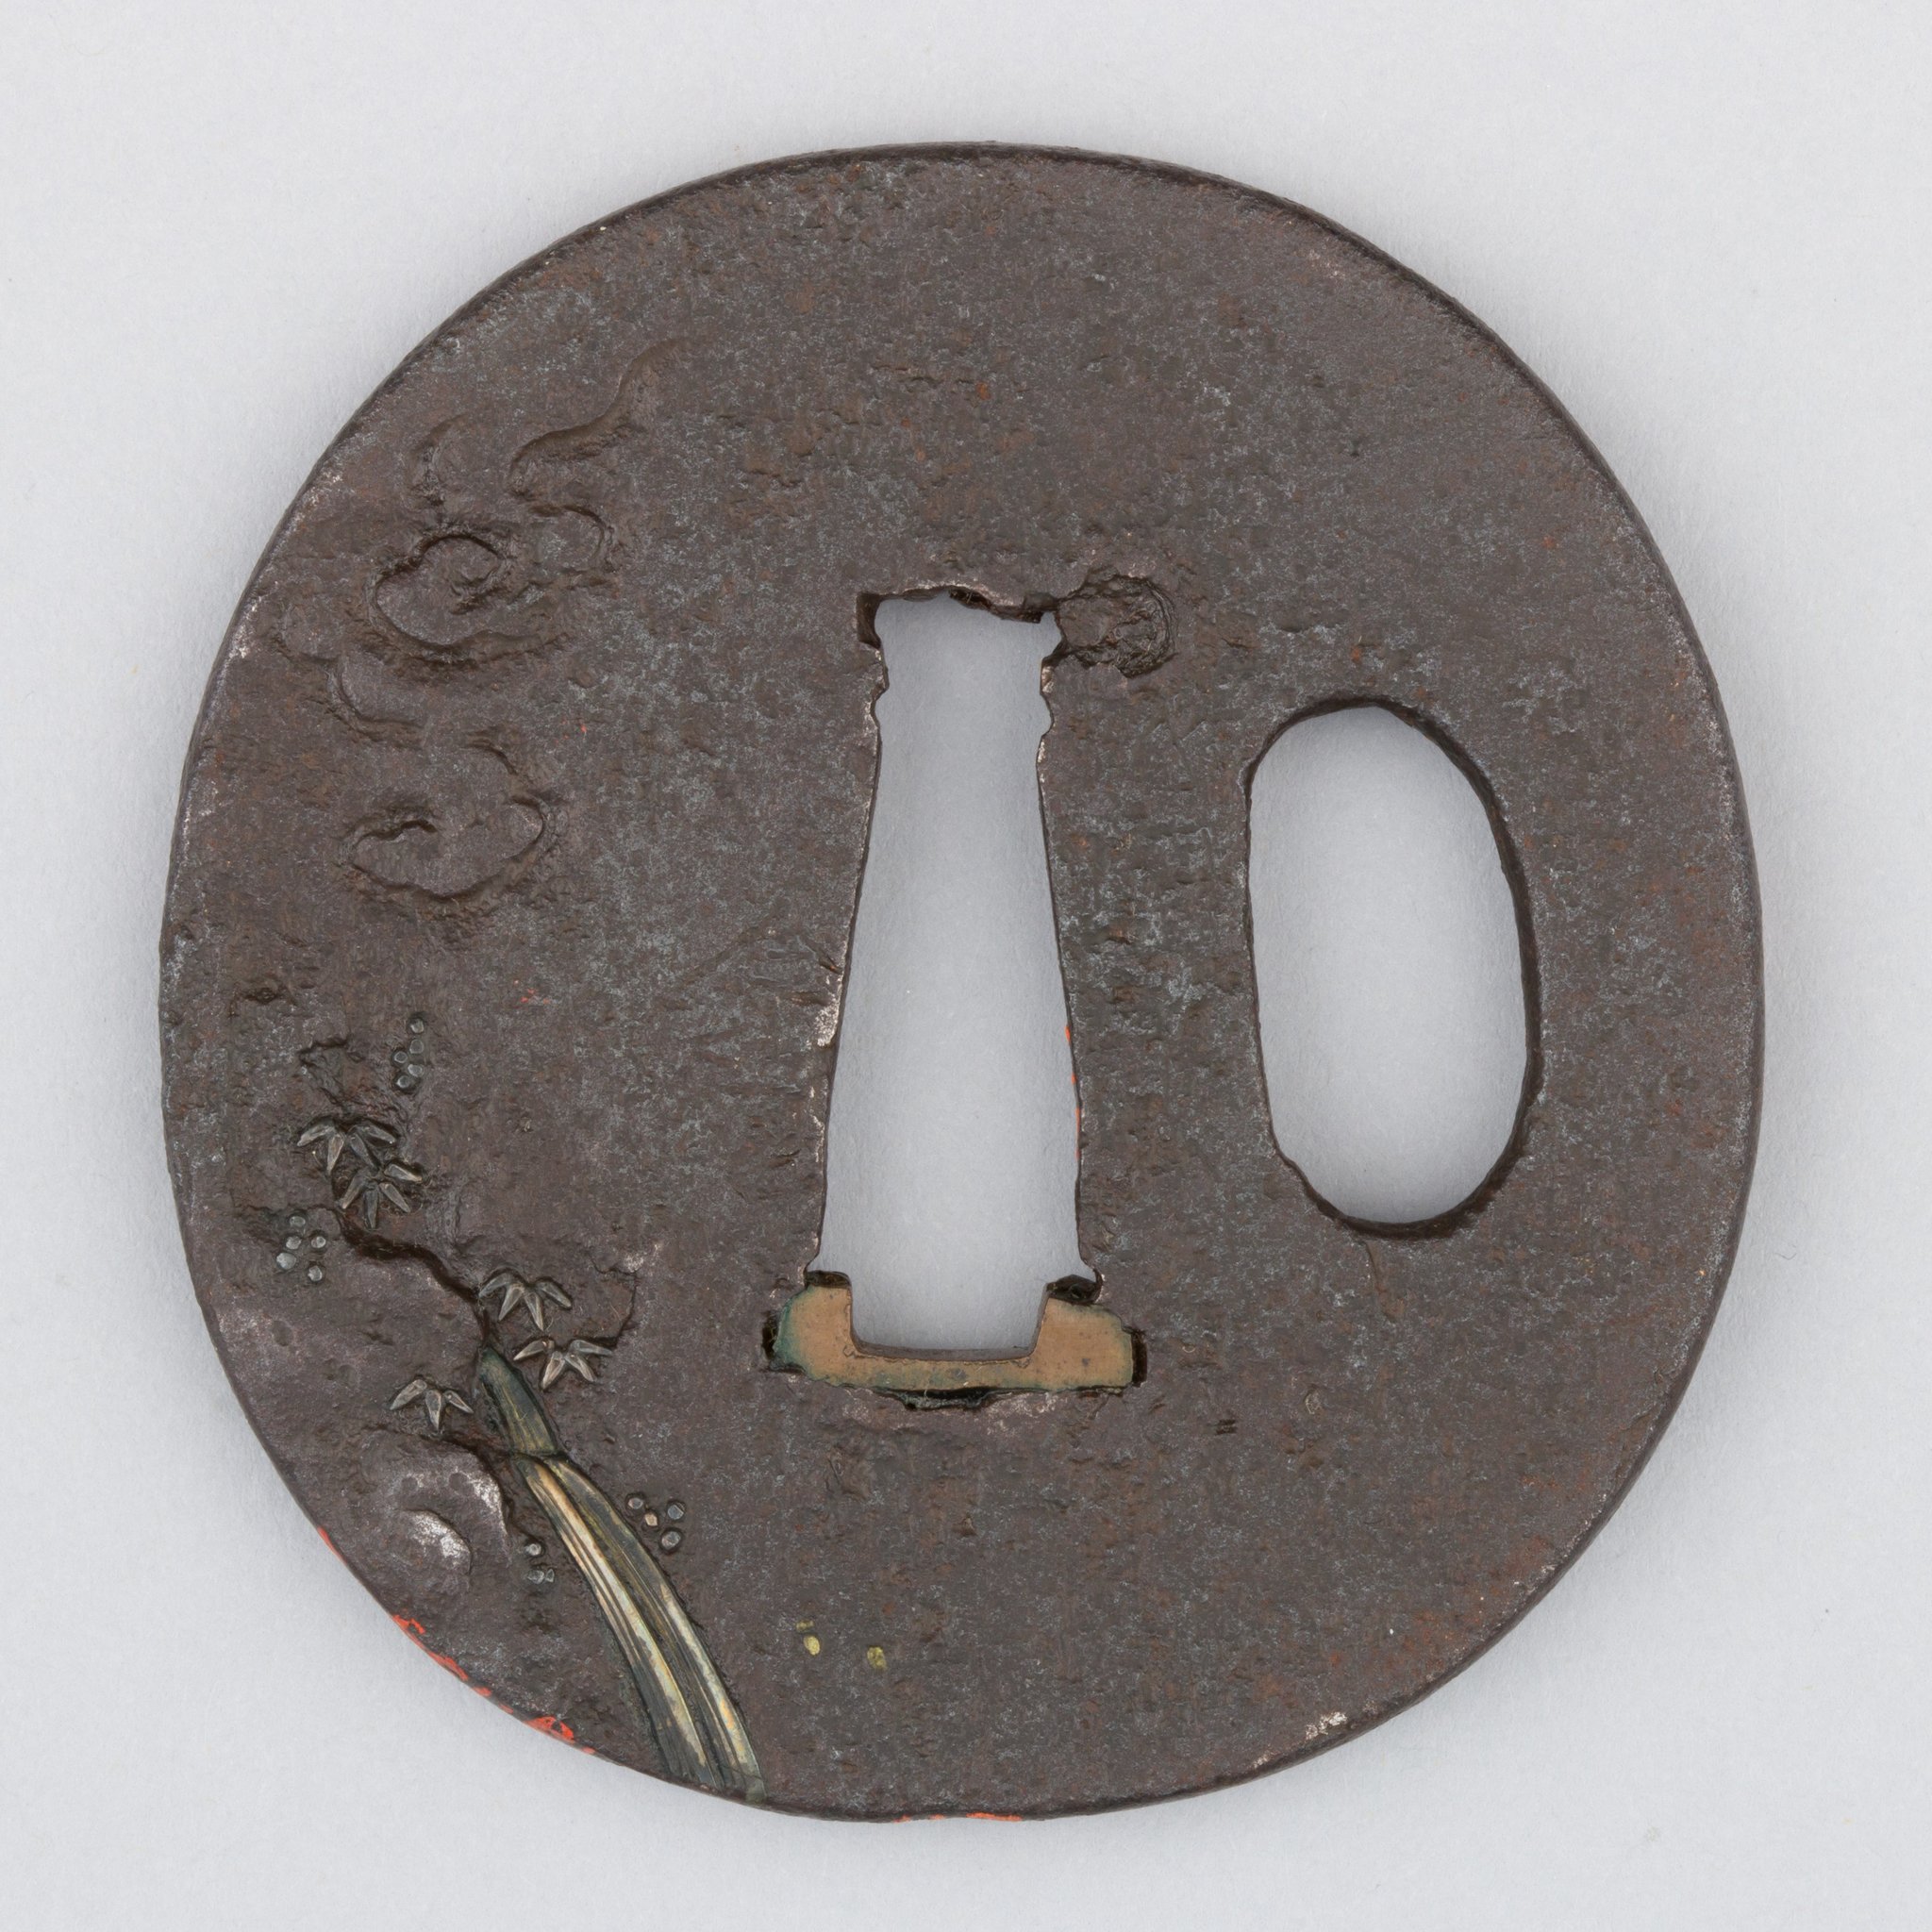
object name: sword guard tsuba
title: Sword Guard (Tsuba)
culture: japanese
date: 1601-1700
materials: copper, gold alloy, gold, iron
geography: japan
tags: men